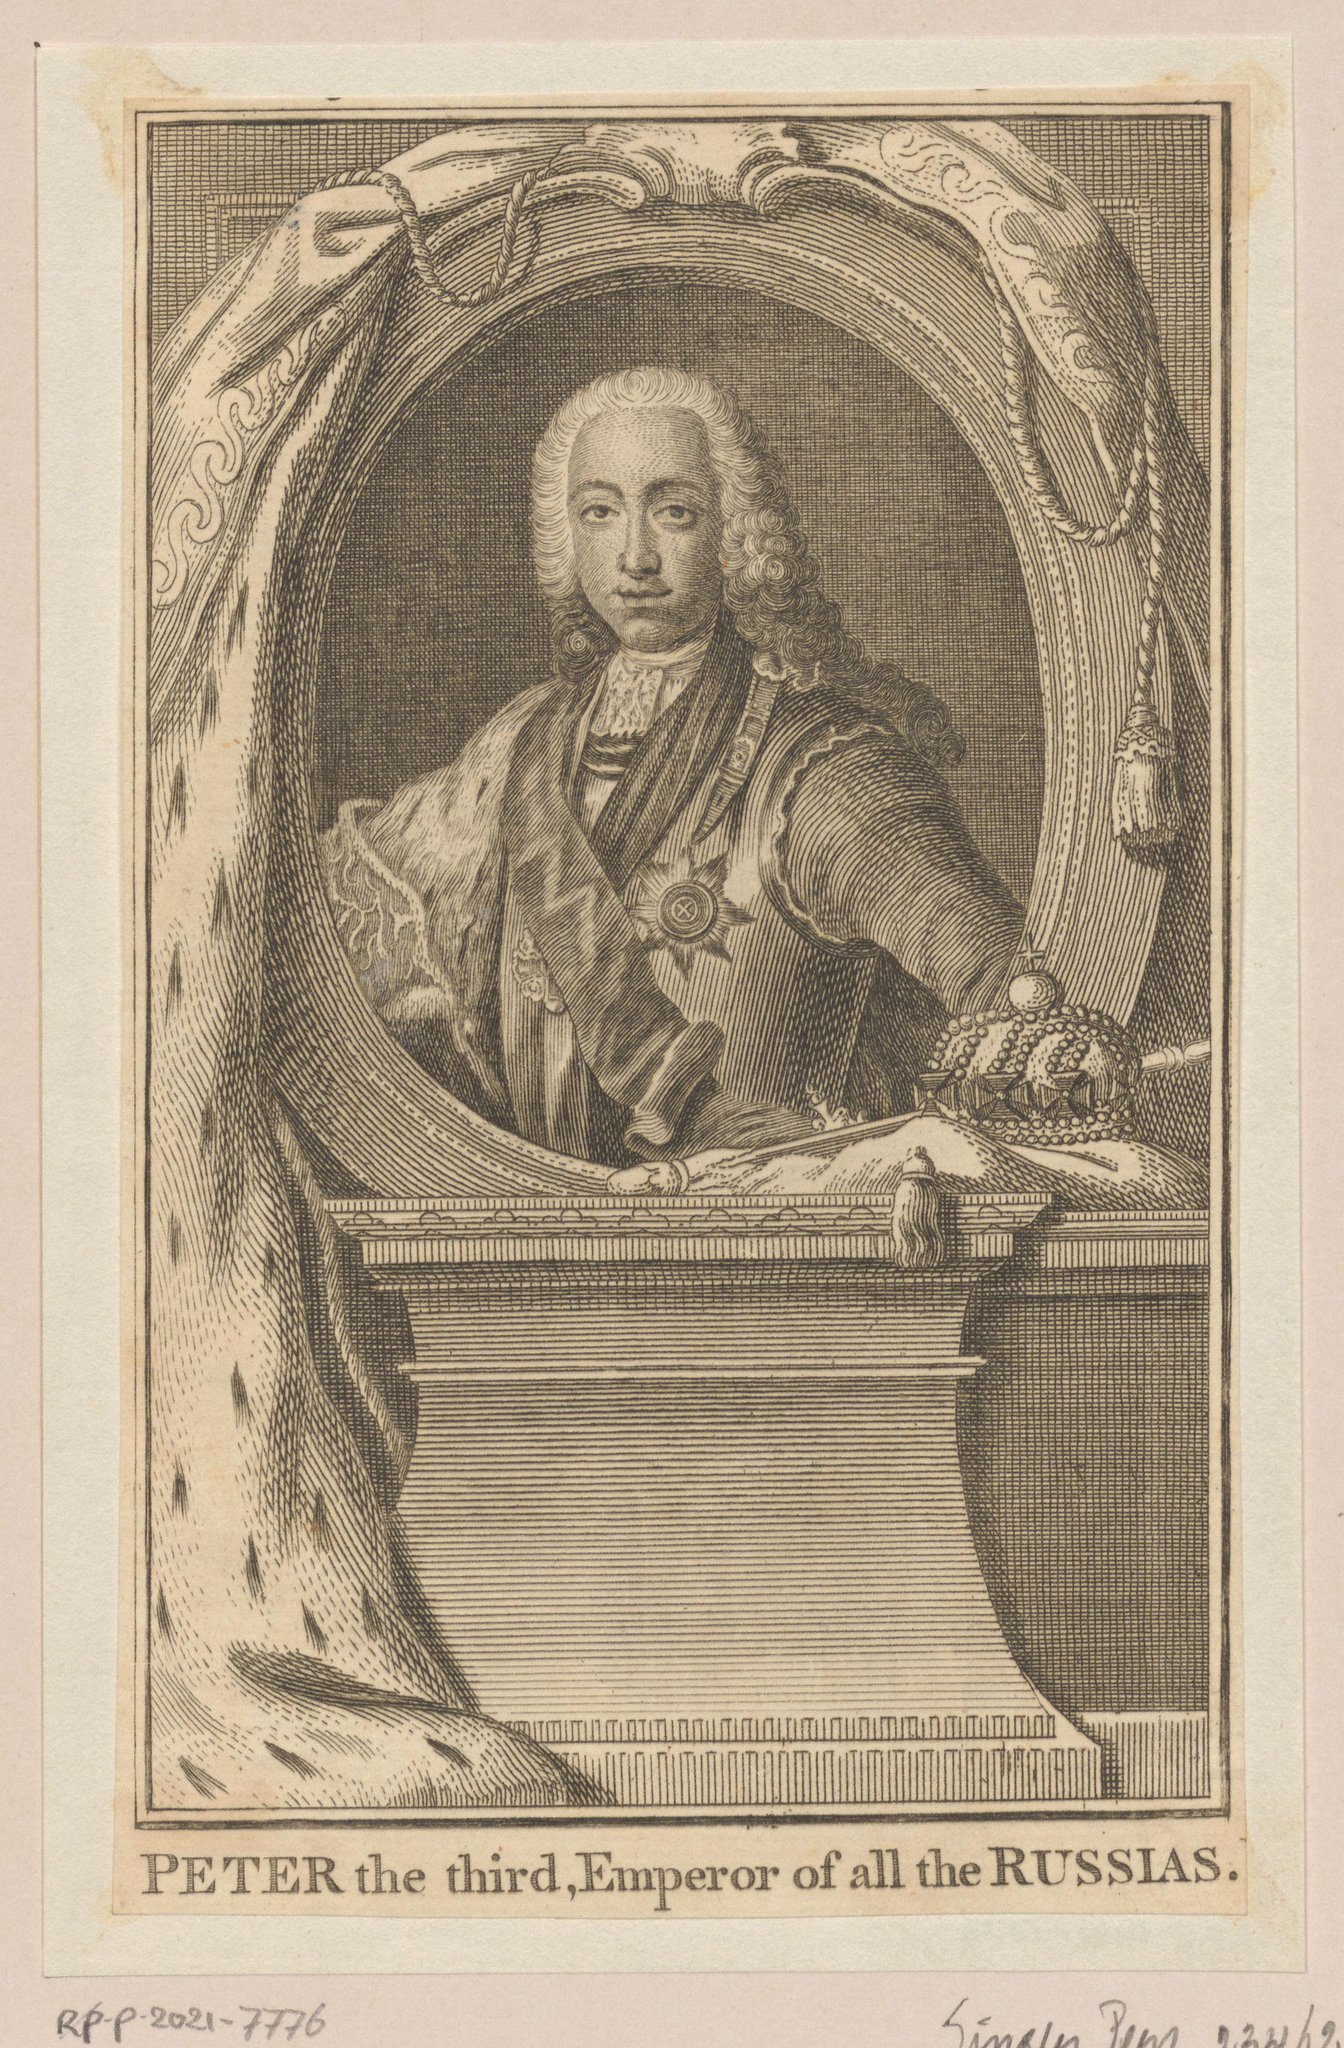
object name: print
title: Portret van Peter III, tsaar van Rusland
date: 1762-1781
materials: paper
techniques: engraving, etching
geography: london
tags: adult man, historical persons, insignia and symbols of sovereignty (crown, diadem, sceptre, orb, seal, standard, cloak, pectoral)